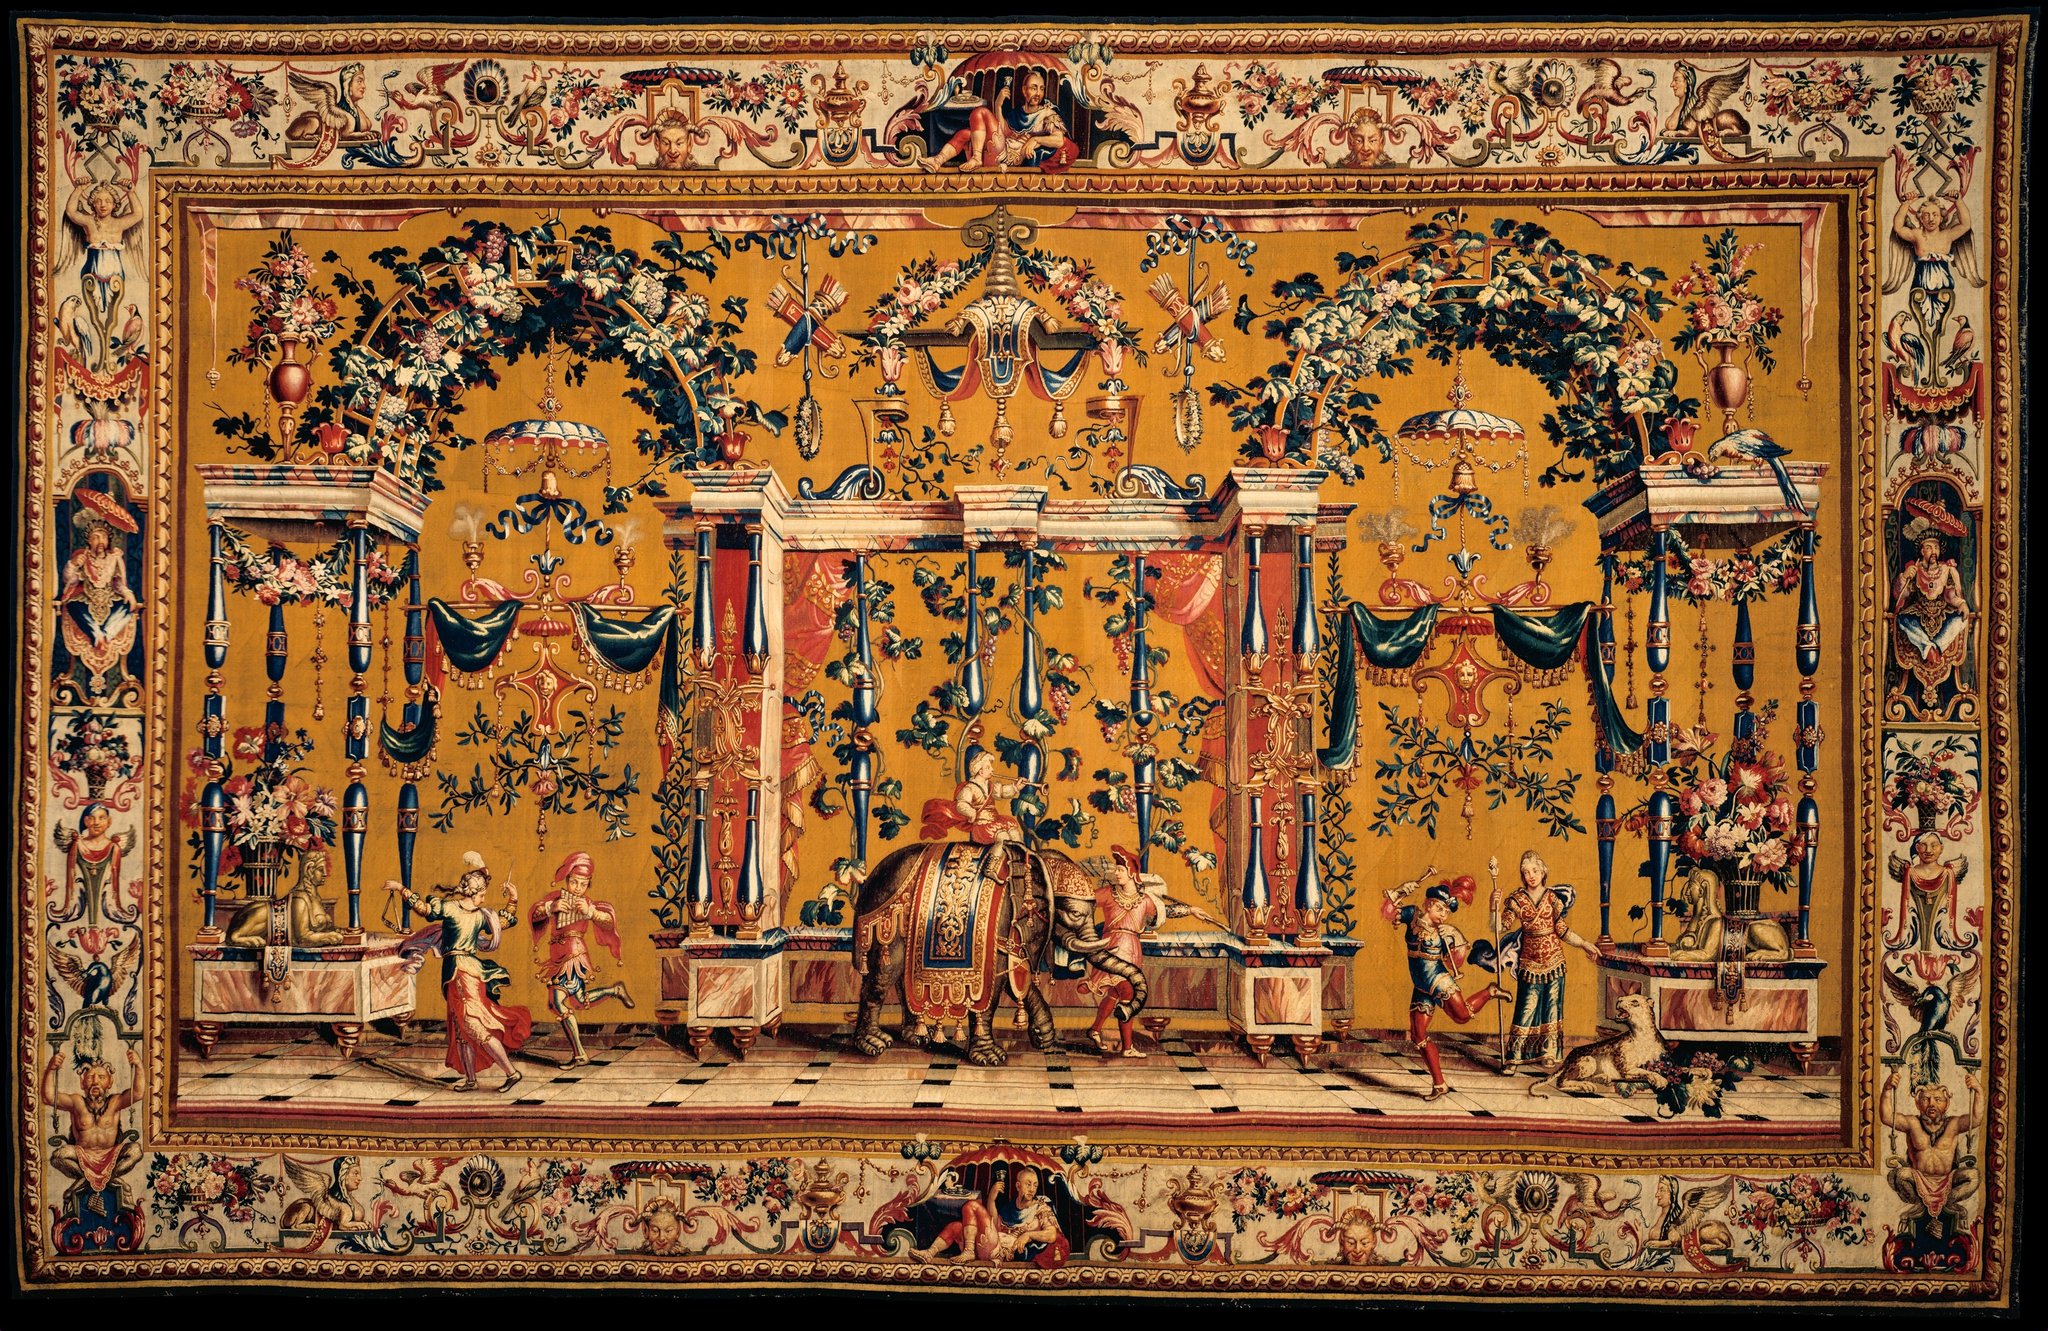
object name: tapestry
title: The Elephant from a set of five Grotesques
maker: jean-baptiste monnoyer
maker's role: designer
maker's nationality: french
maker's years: 1636-1699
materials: silk, wool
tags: birds,men,women,dancing,sphinx,elephants,leopards